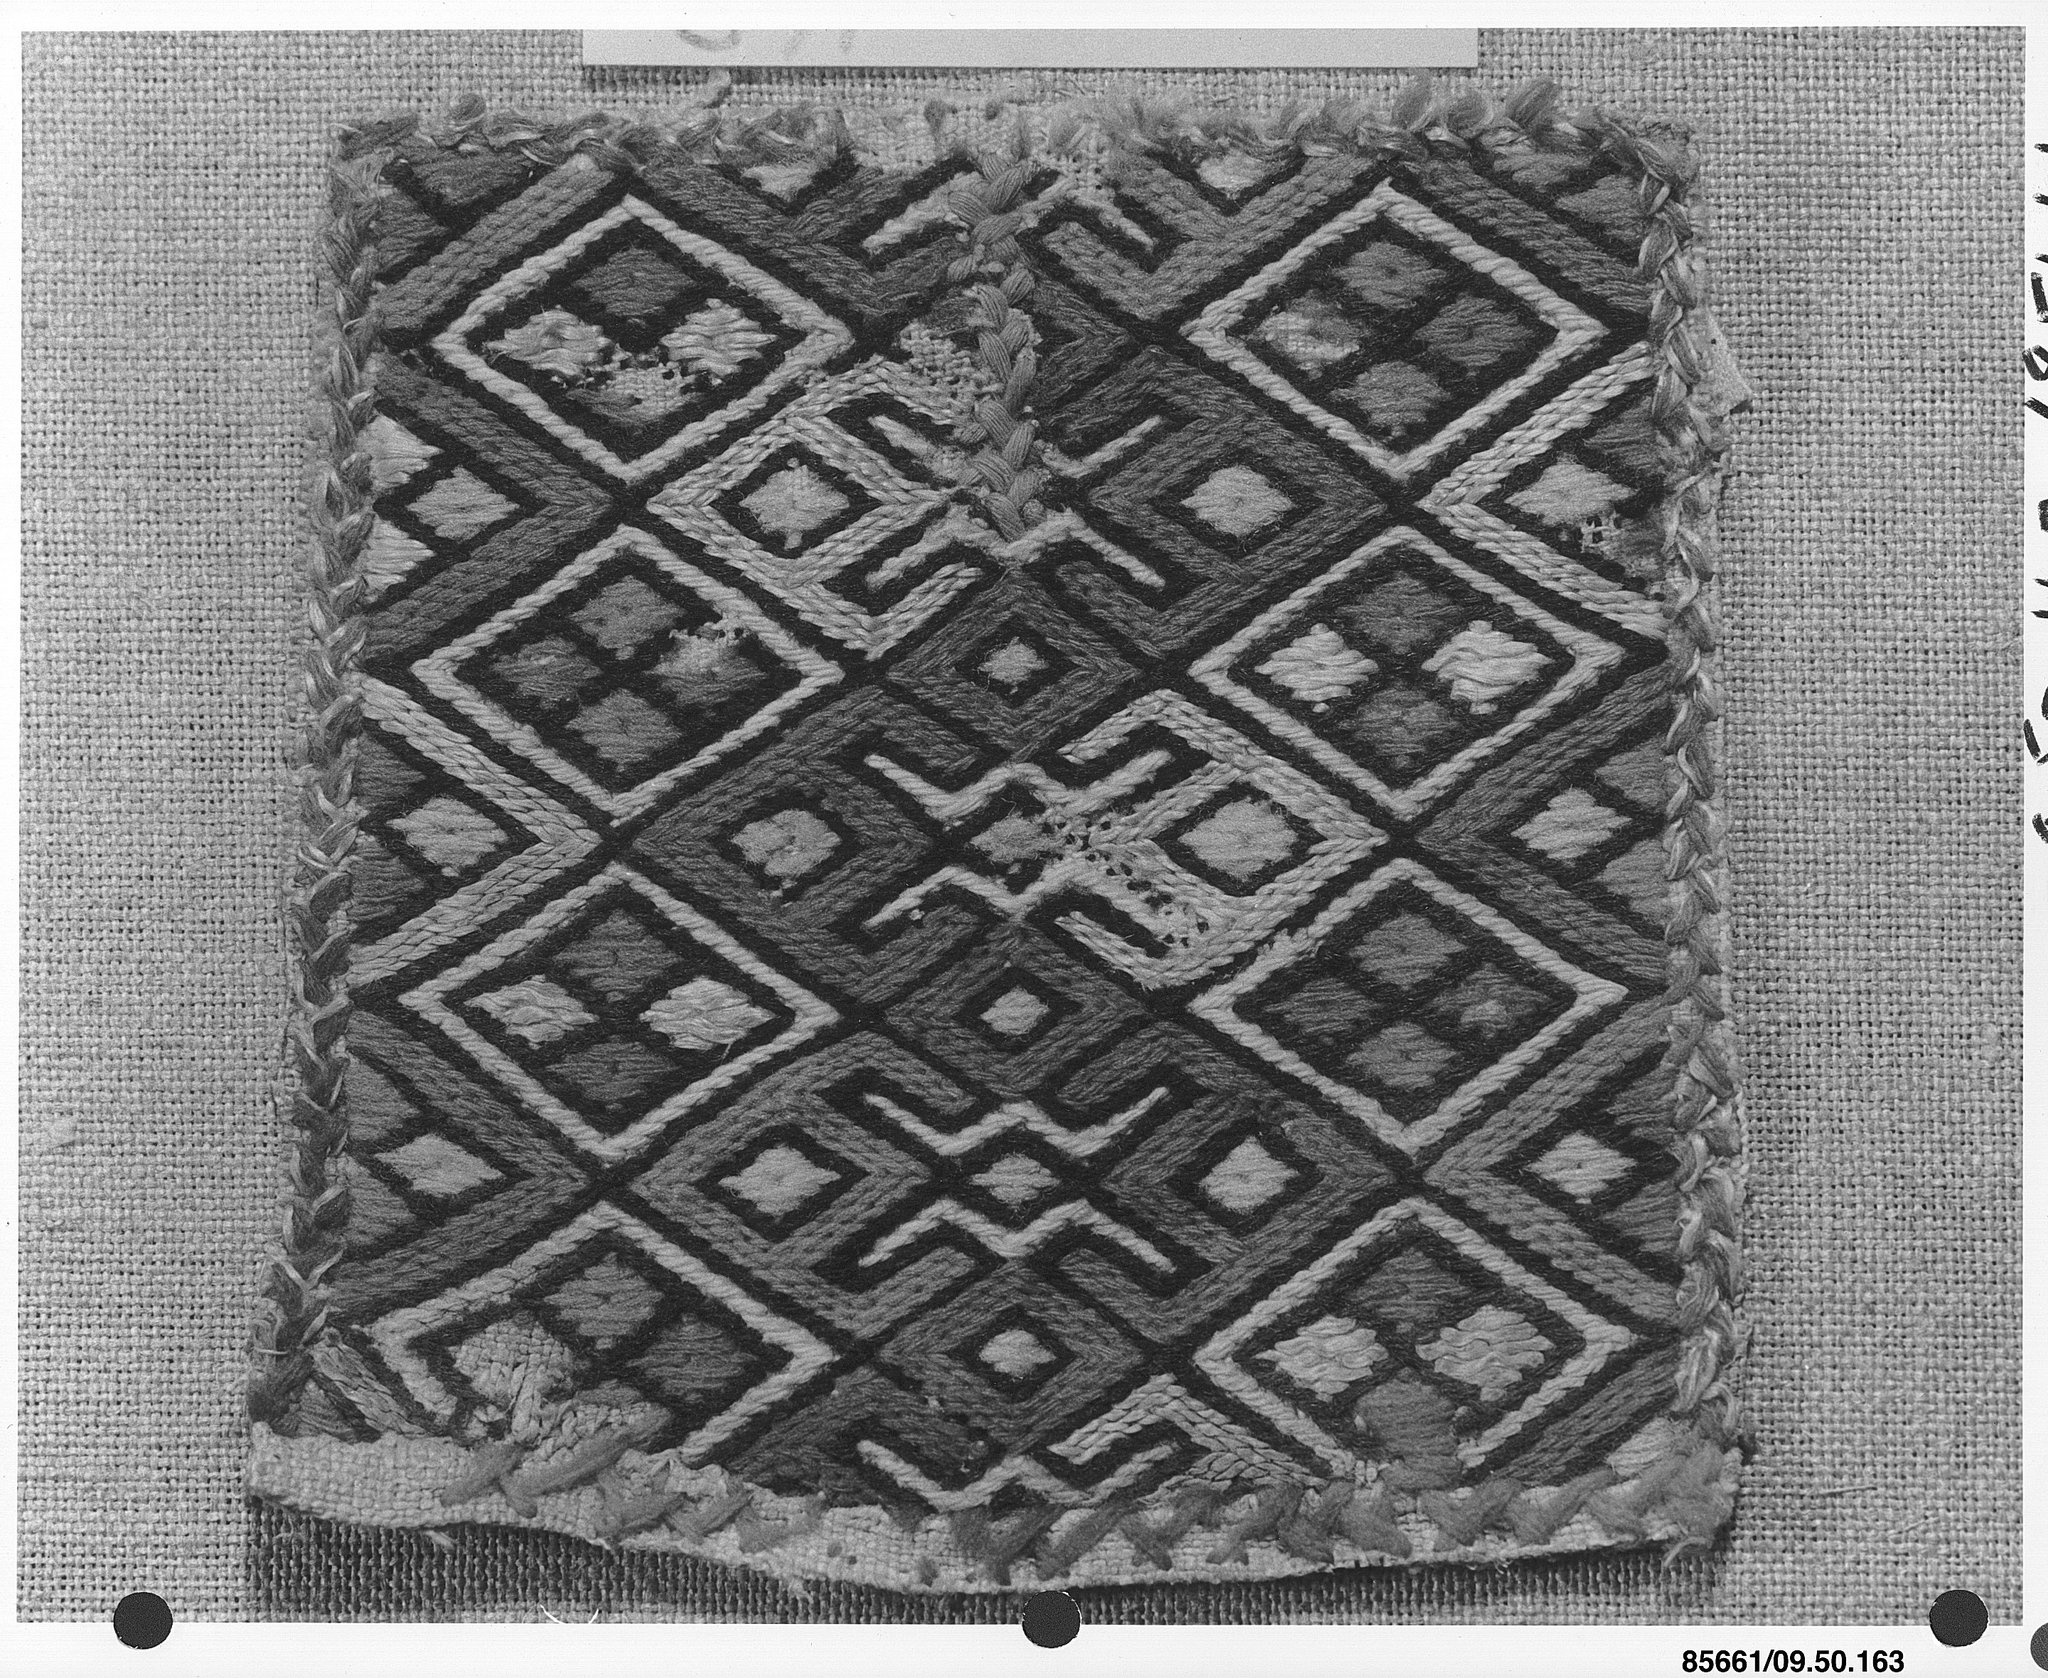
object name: costume fragment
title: Peasant costume fragment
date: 1701-1900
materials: canvas, silk, wool